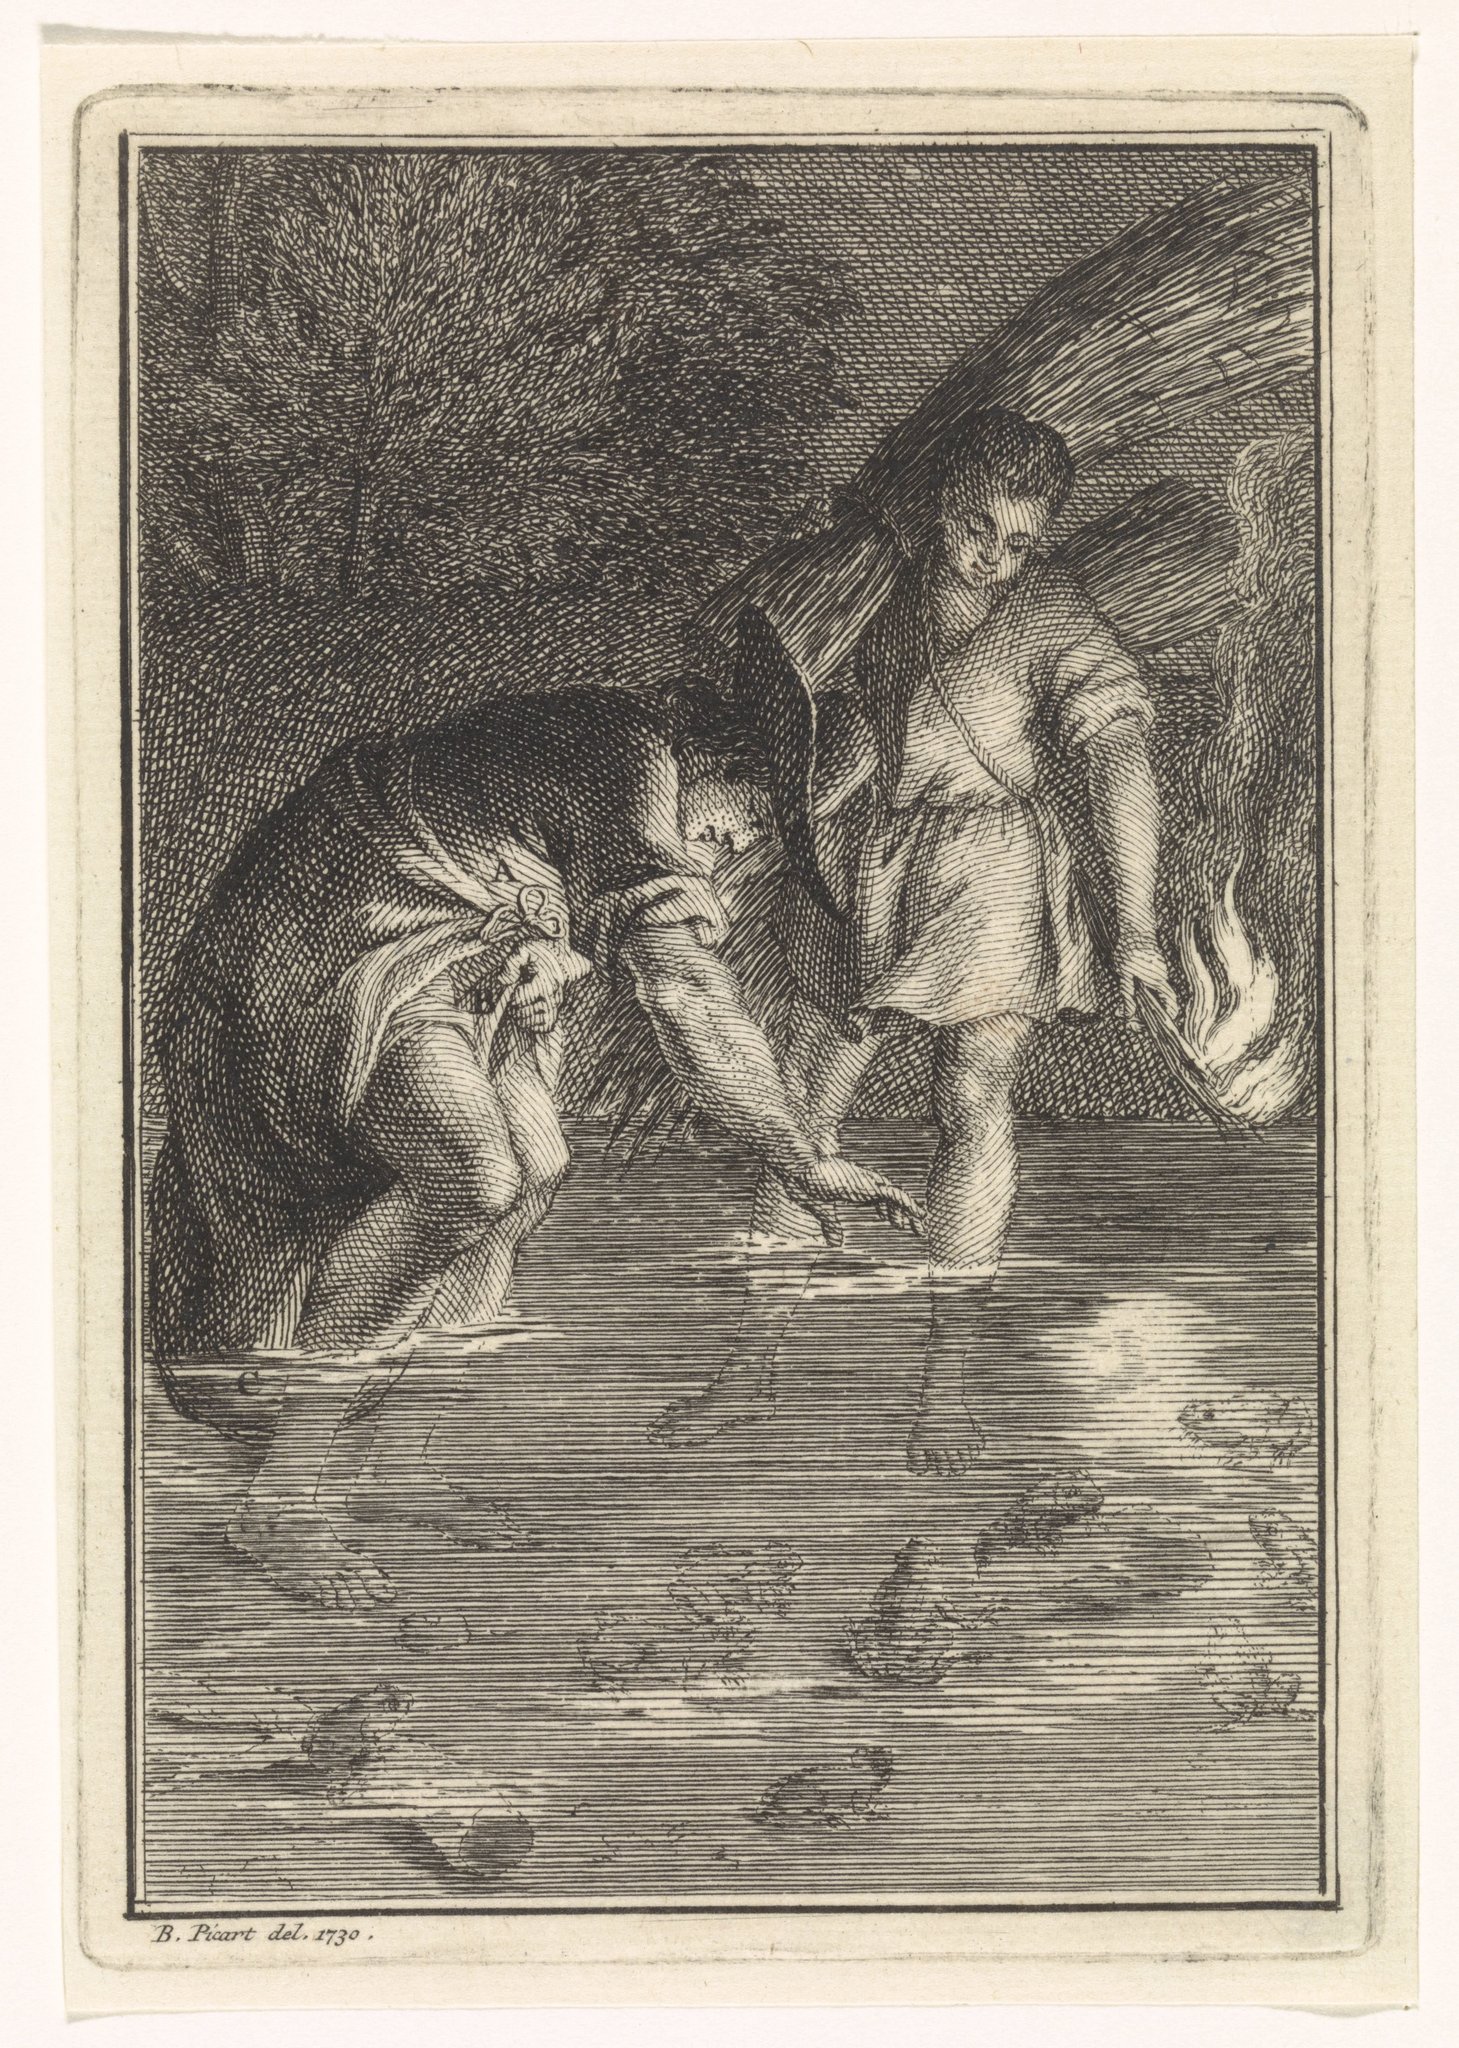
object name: book illustration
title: Vangen van kikkers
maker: bernard picart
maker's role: draughtsman, print maker, publisher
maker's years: 1673-1733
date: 1730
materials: paper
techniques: engraving, etching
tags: tailless amphibians: frog, catching animals, night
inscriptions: collector's mark: Lugt 2233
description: Twee mannen staan in een rivier bij nacht. Eén van hen houdt een brandende fakkel in de hand terwijl de ander de kikkers met zijn blote handen probeert te vangen. Details in de voorstelling zijn met letters aangeduid die vermoedelijk bij een legenda horen.